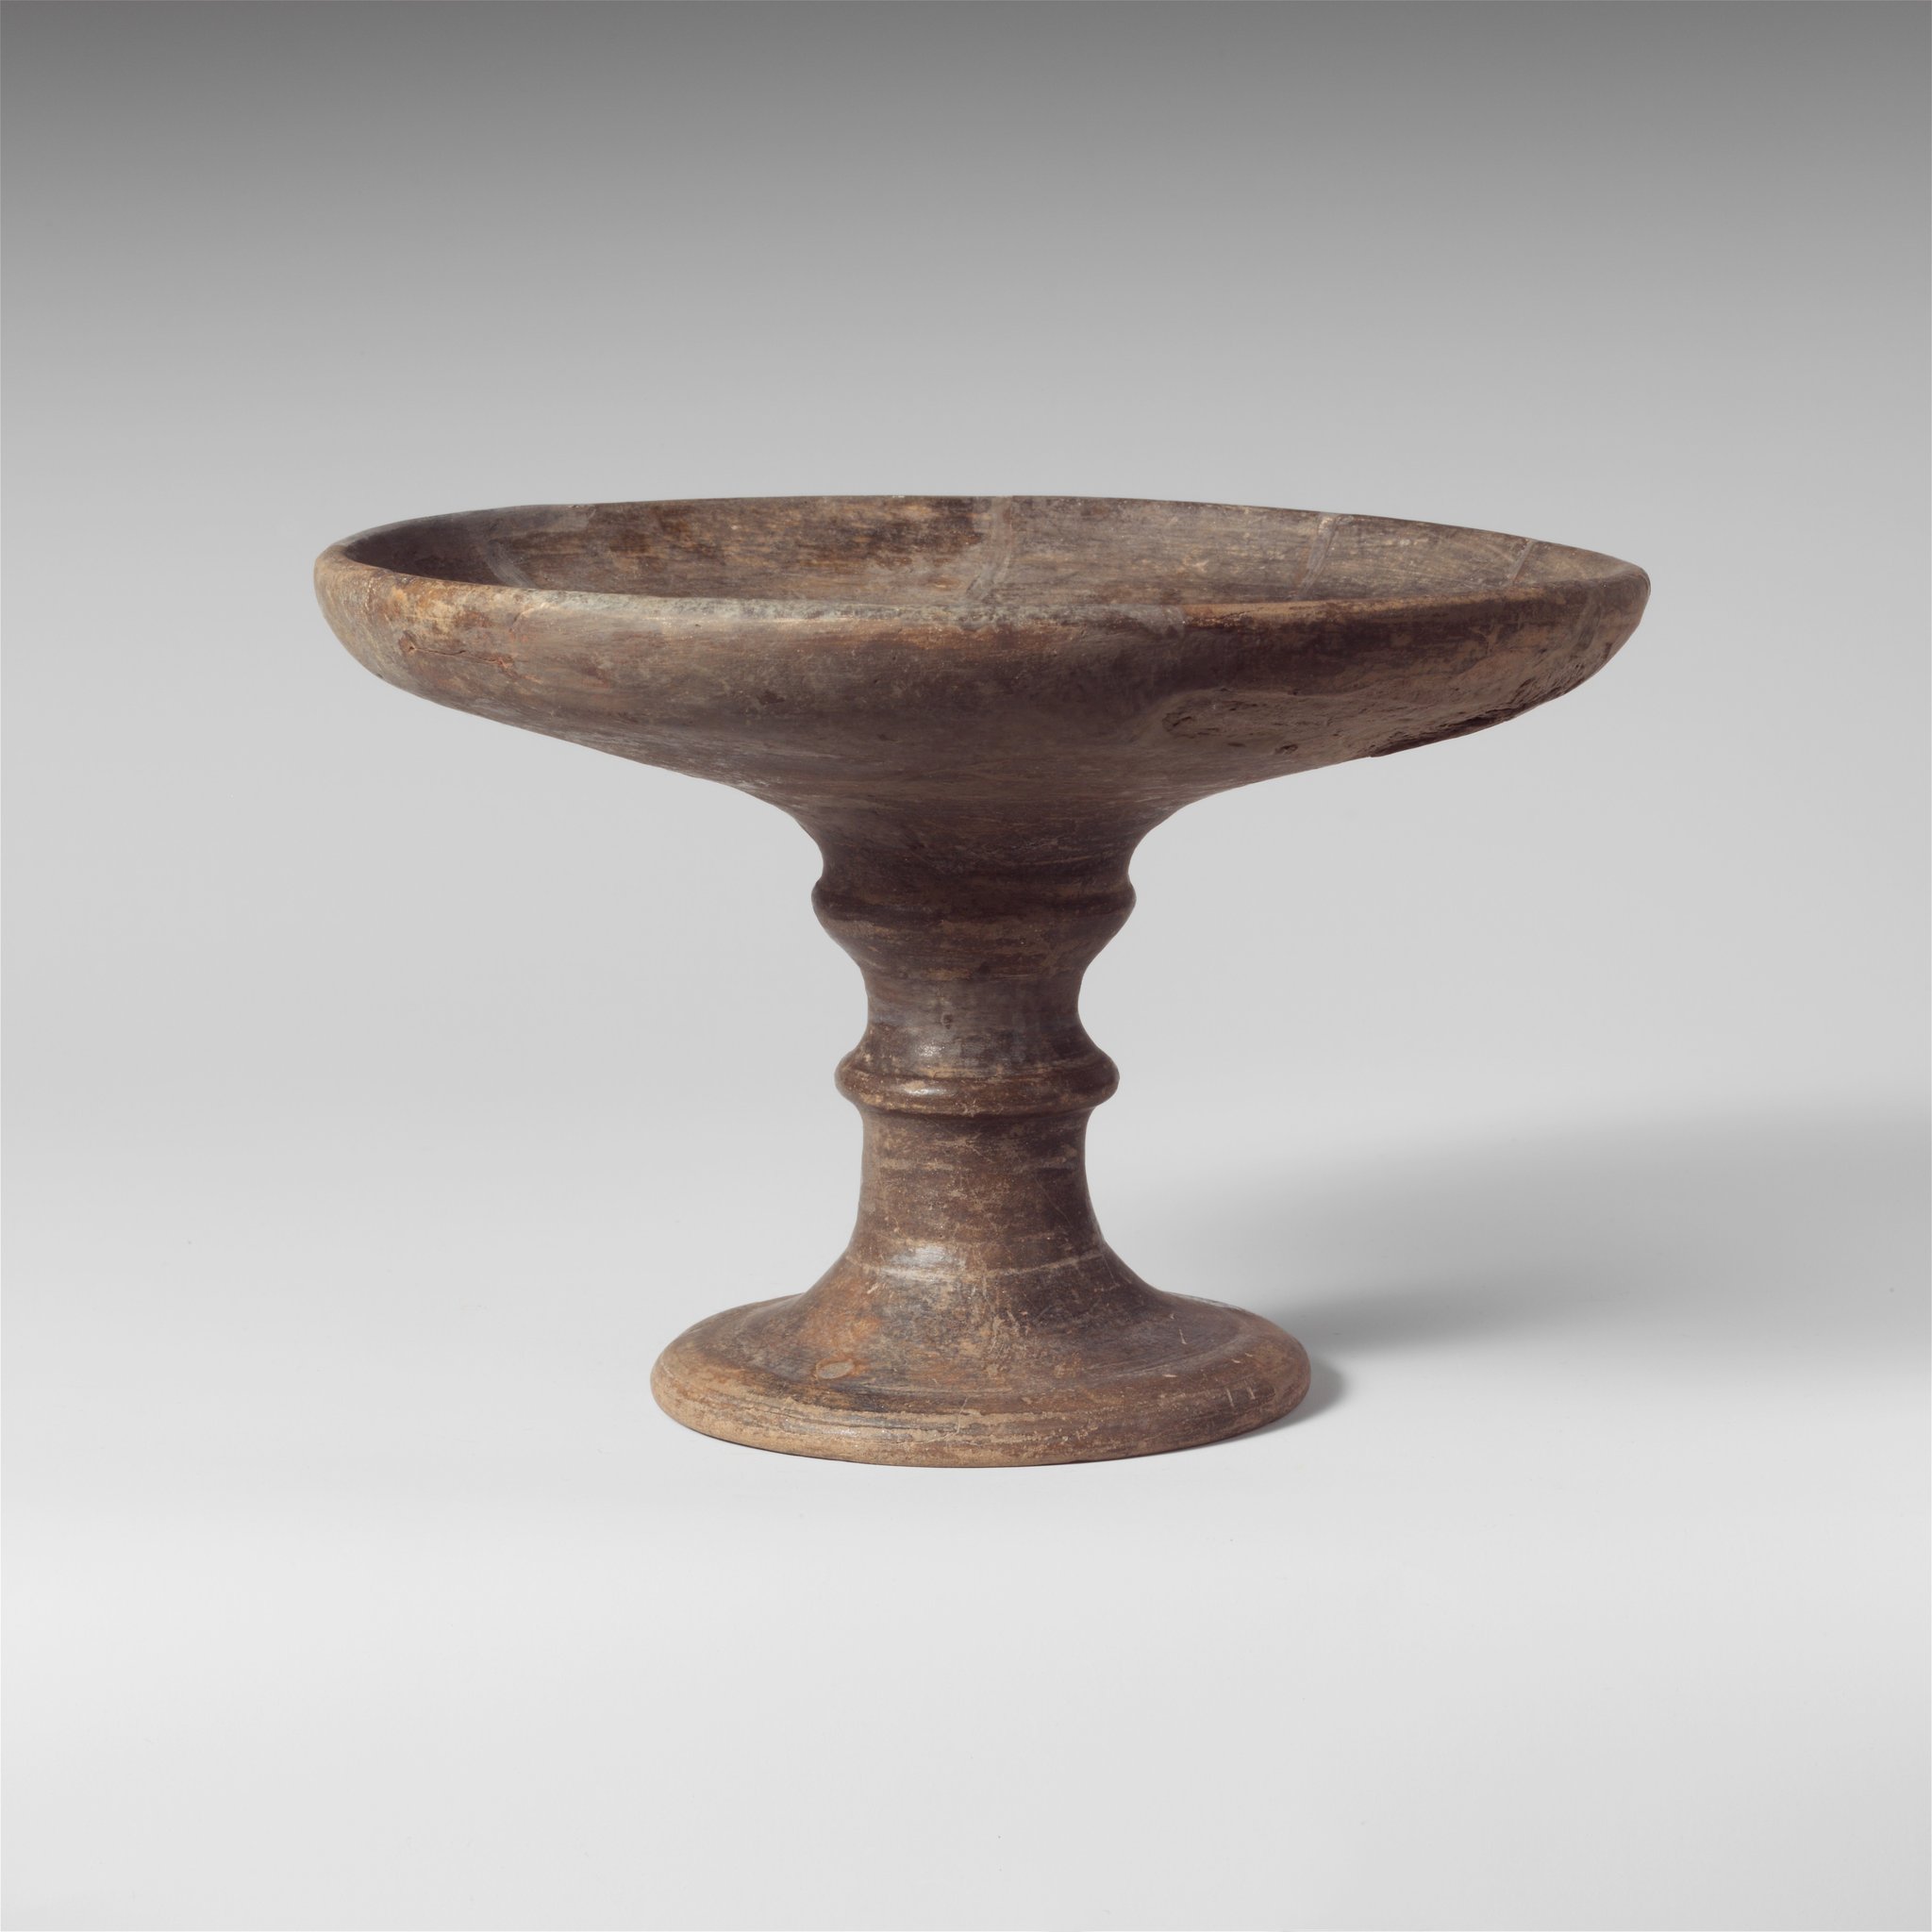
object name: stemmed dish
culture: lydian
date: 600-501 BCE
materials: terracotta